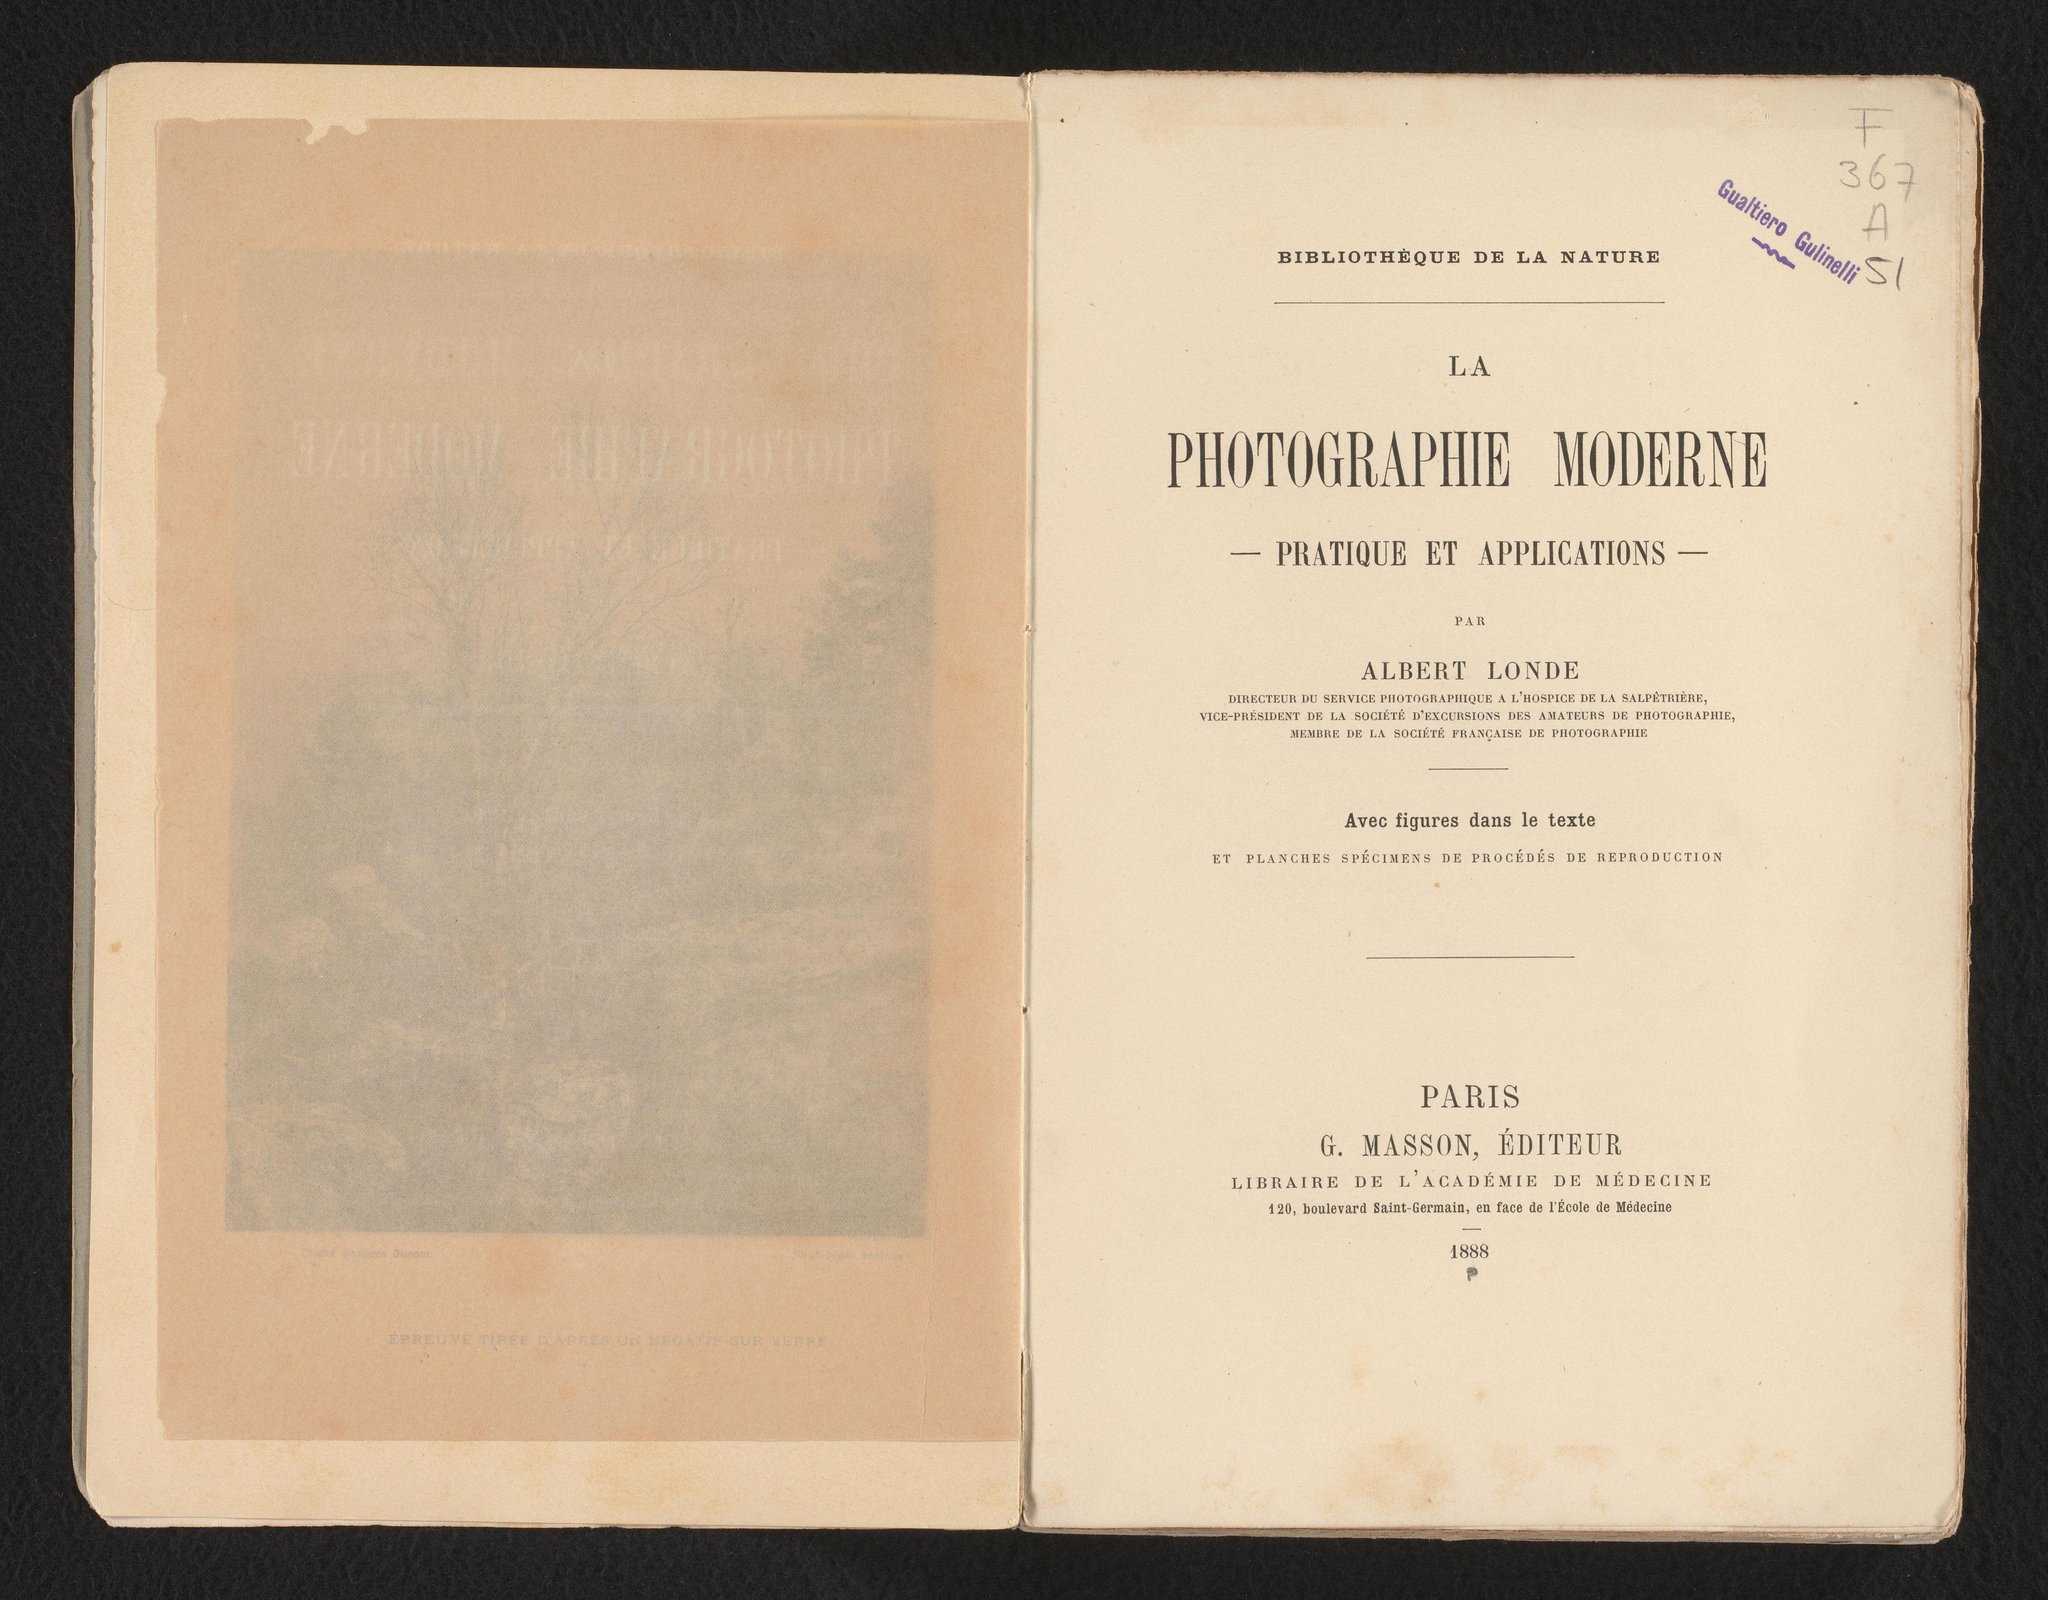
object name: book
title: La photographie moderne : pratique et applications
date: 1888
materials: paper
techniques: photograph, letterpress printing, photoaquatint, engraving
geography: corbeil